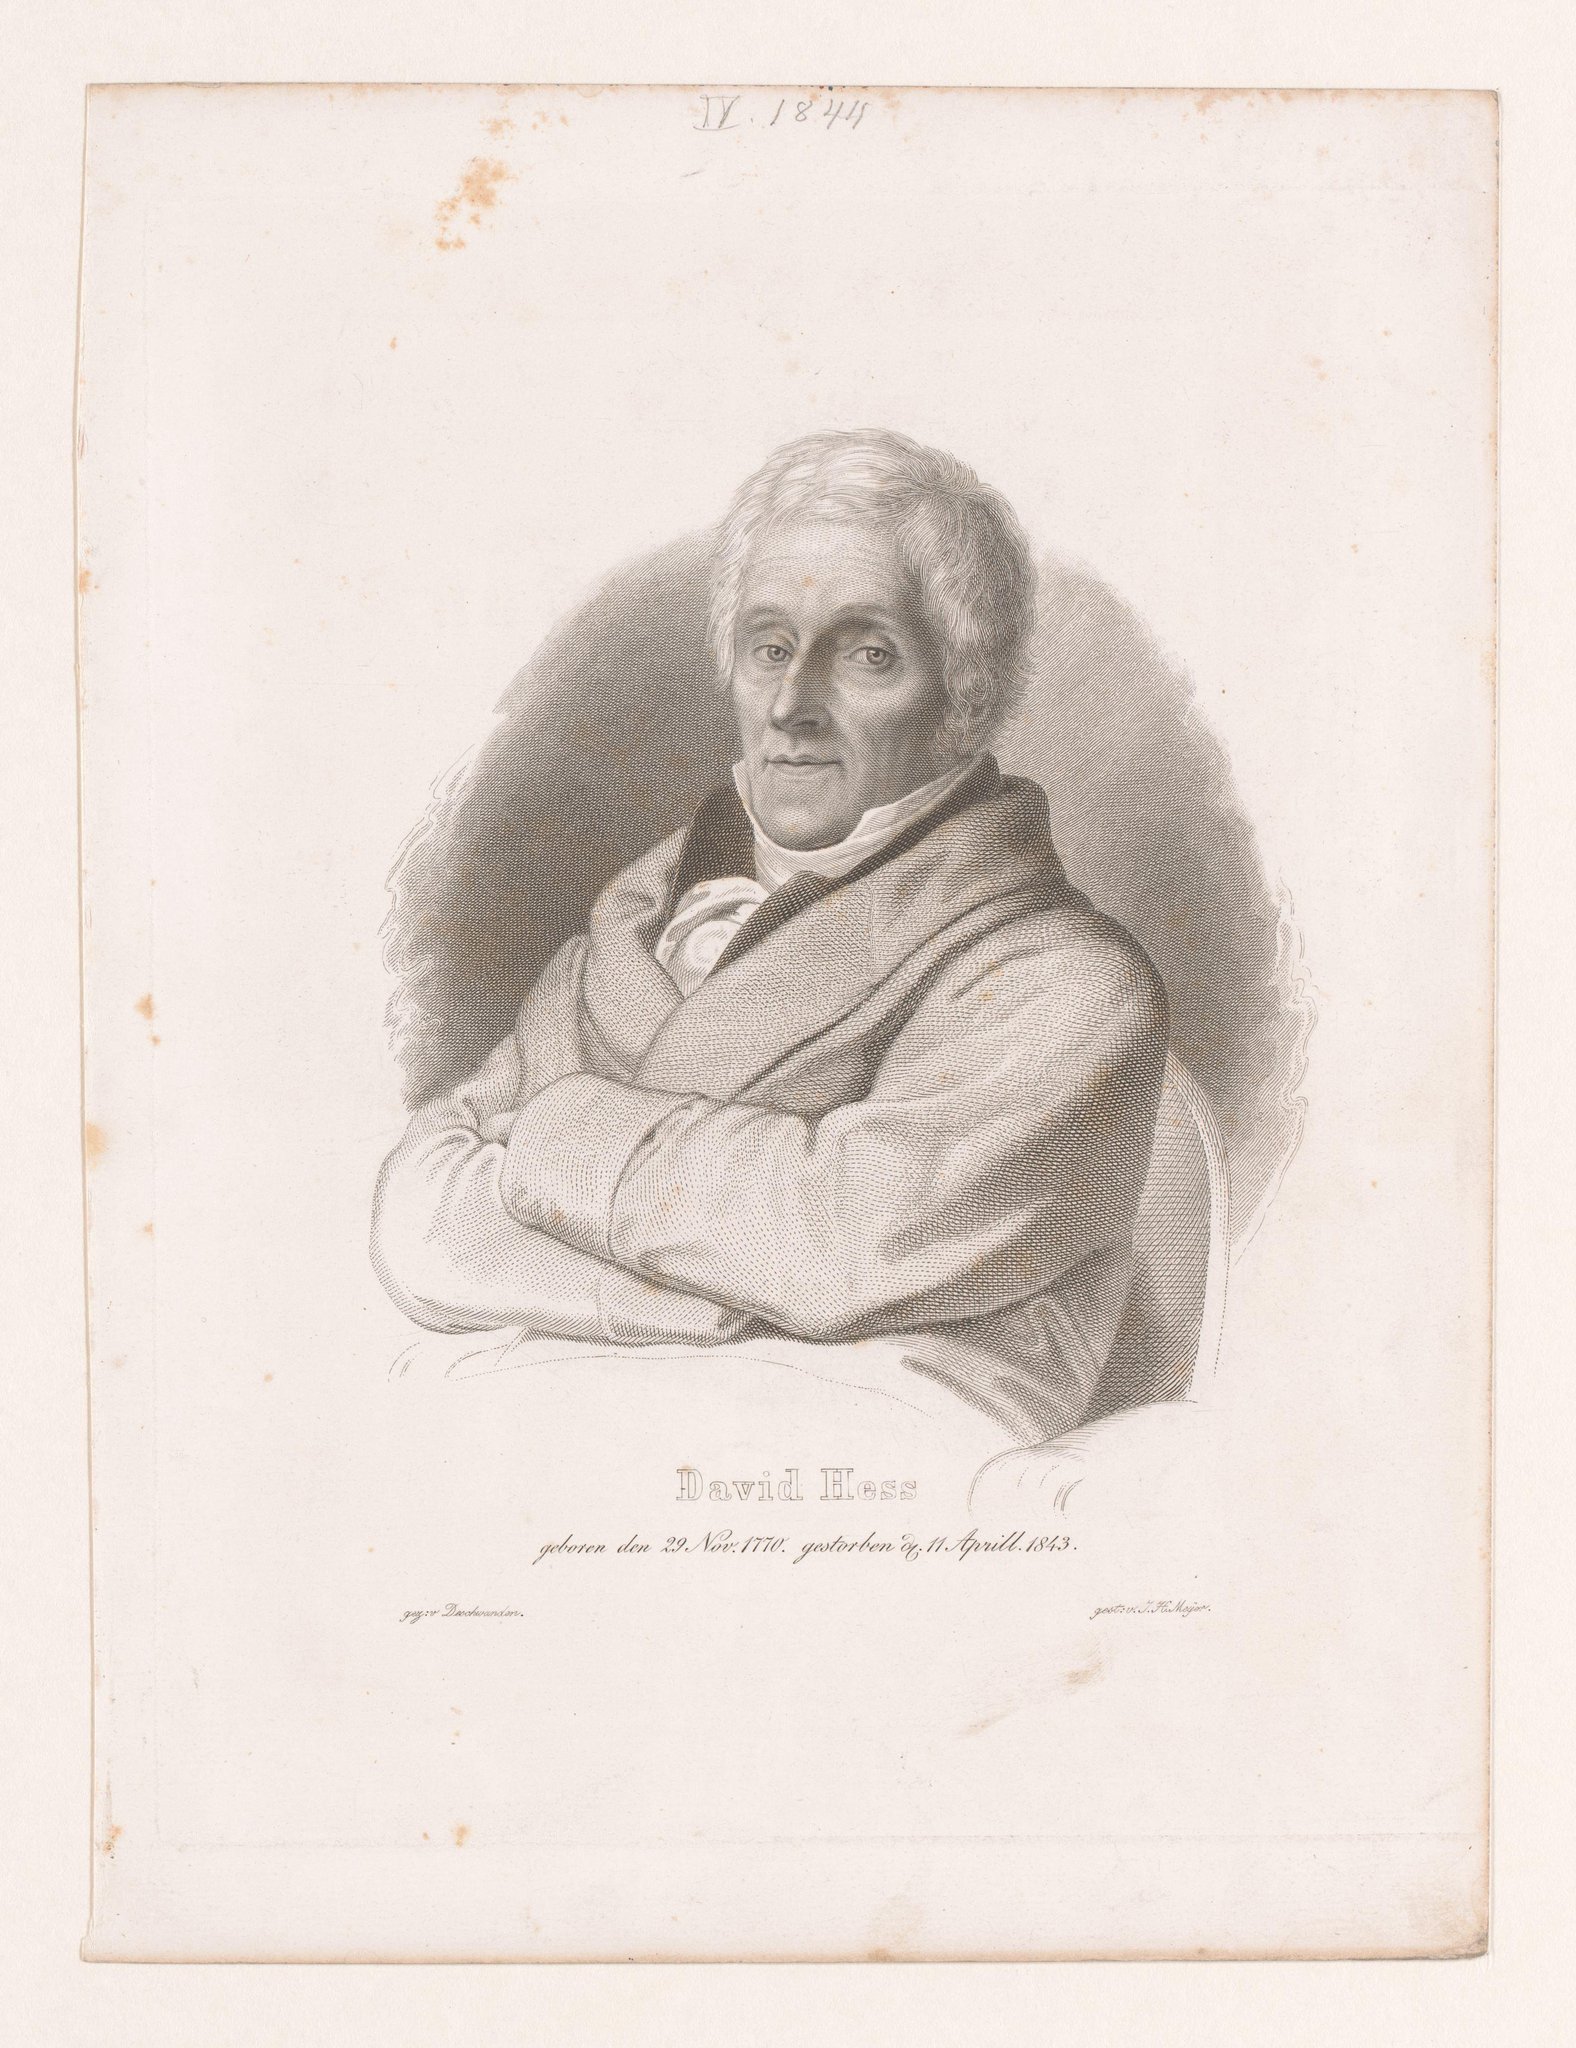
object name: print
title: Portret van David Hess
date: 1843-1877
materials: paper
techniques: engraving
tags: draughtsman, david hess, historical persons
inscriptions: collector's mark: Lugt 2228